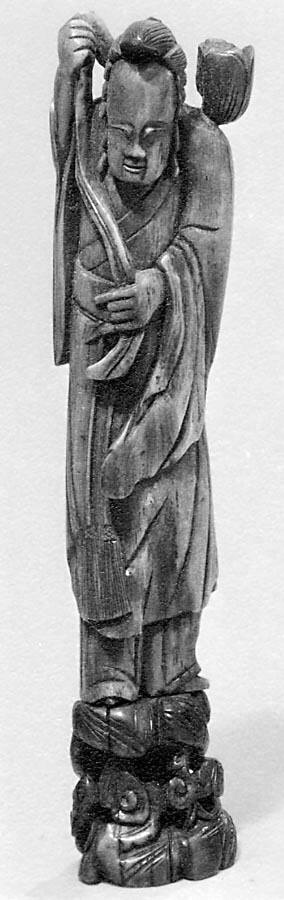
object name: statuette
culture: chinese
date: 1801-1900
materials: ivory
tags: men